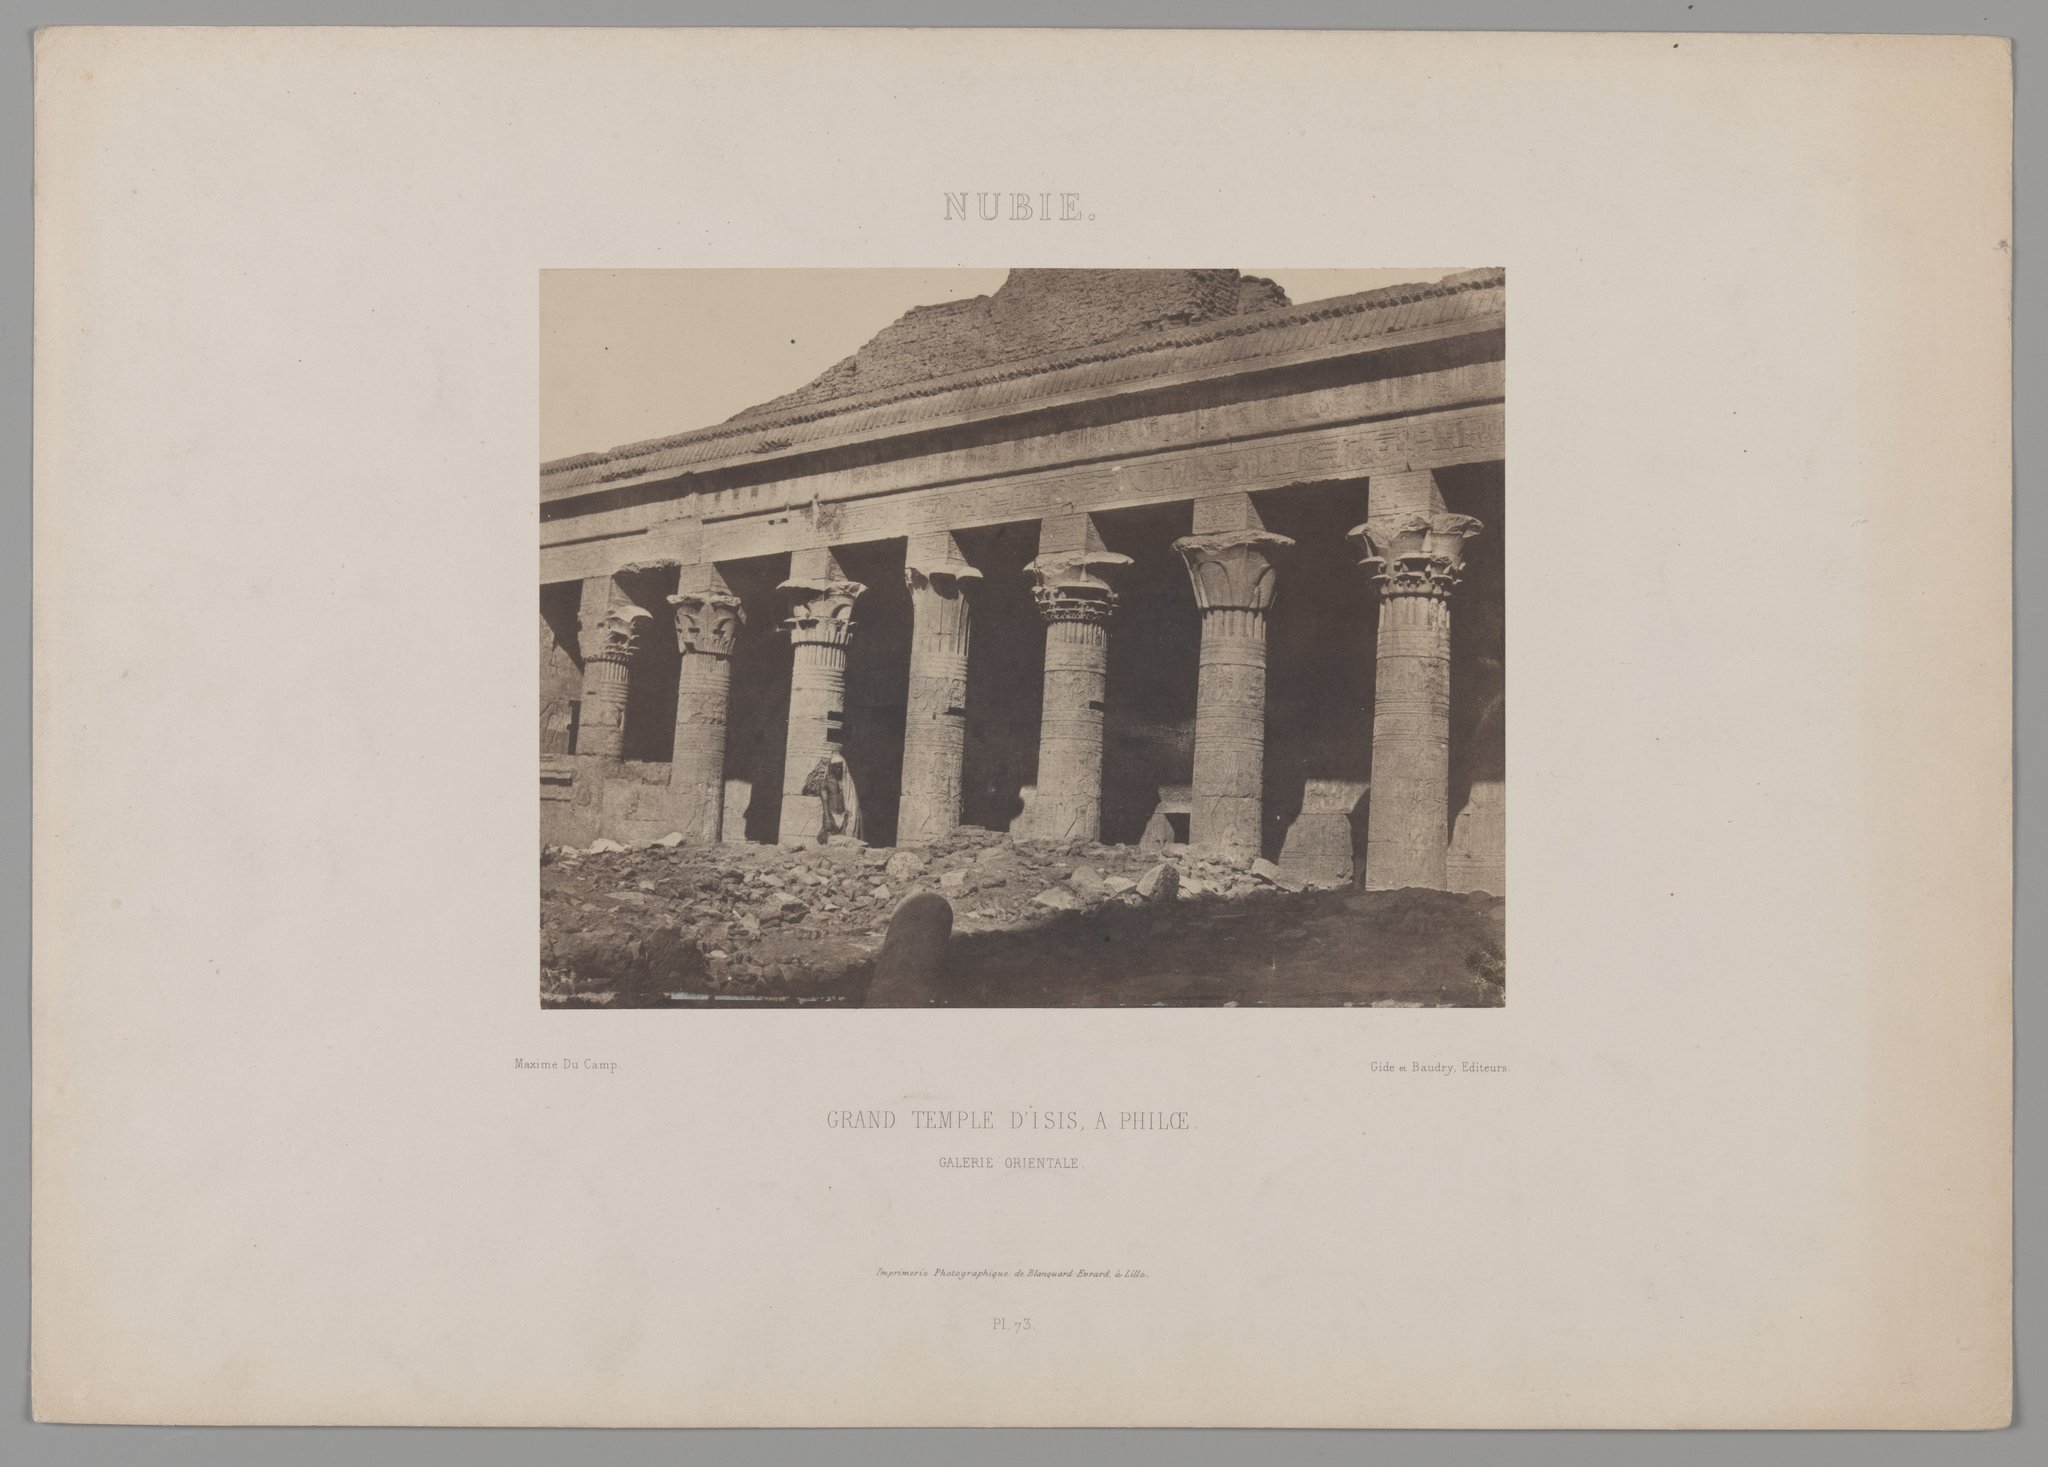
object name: photograph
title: Nubie, Grand Temple d'Isis, a Philœ, Galerie Orientale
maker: maxime du camp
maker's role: artist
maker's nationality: french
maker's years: 1822-1894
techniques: paper negative, salted paper print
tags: architecture,temples,ruins